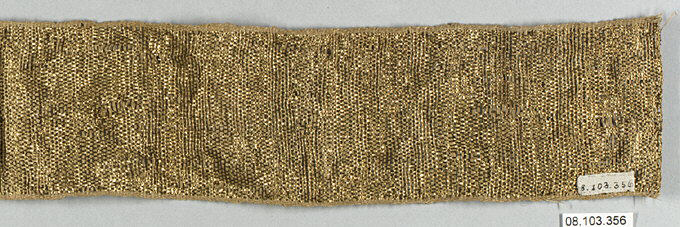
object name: galloon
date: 1601-1800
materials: metal thread